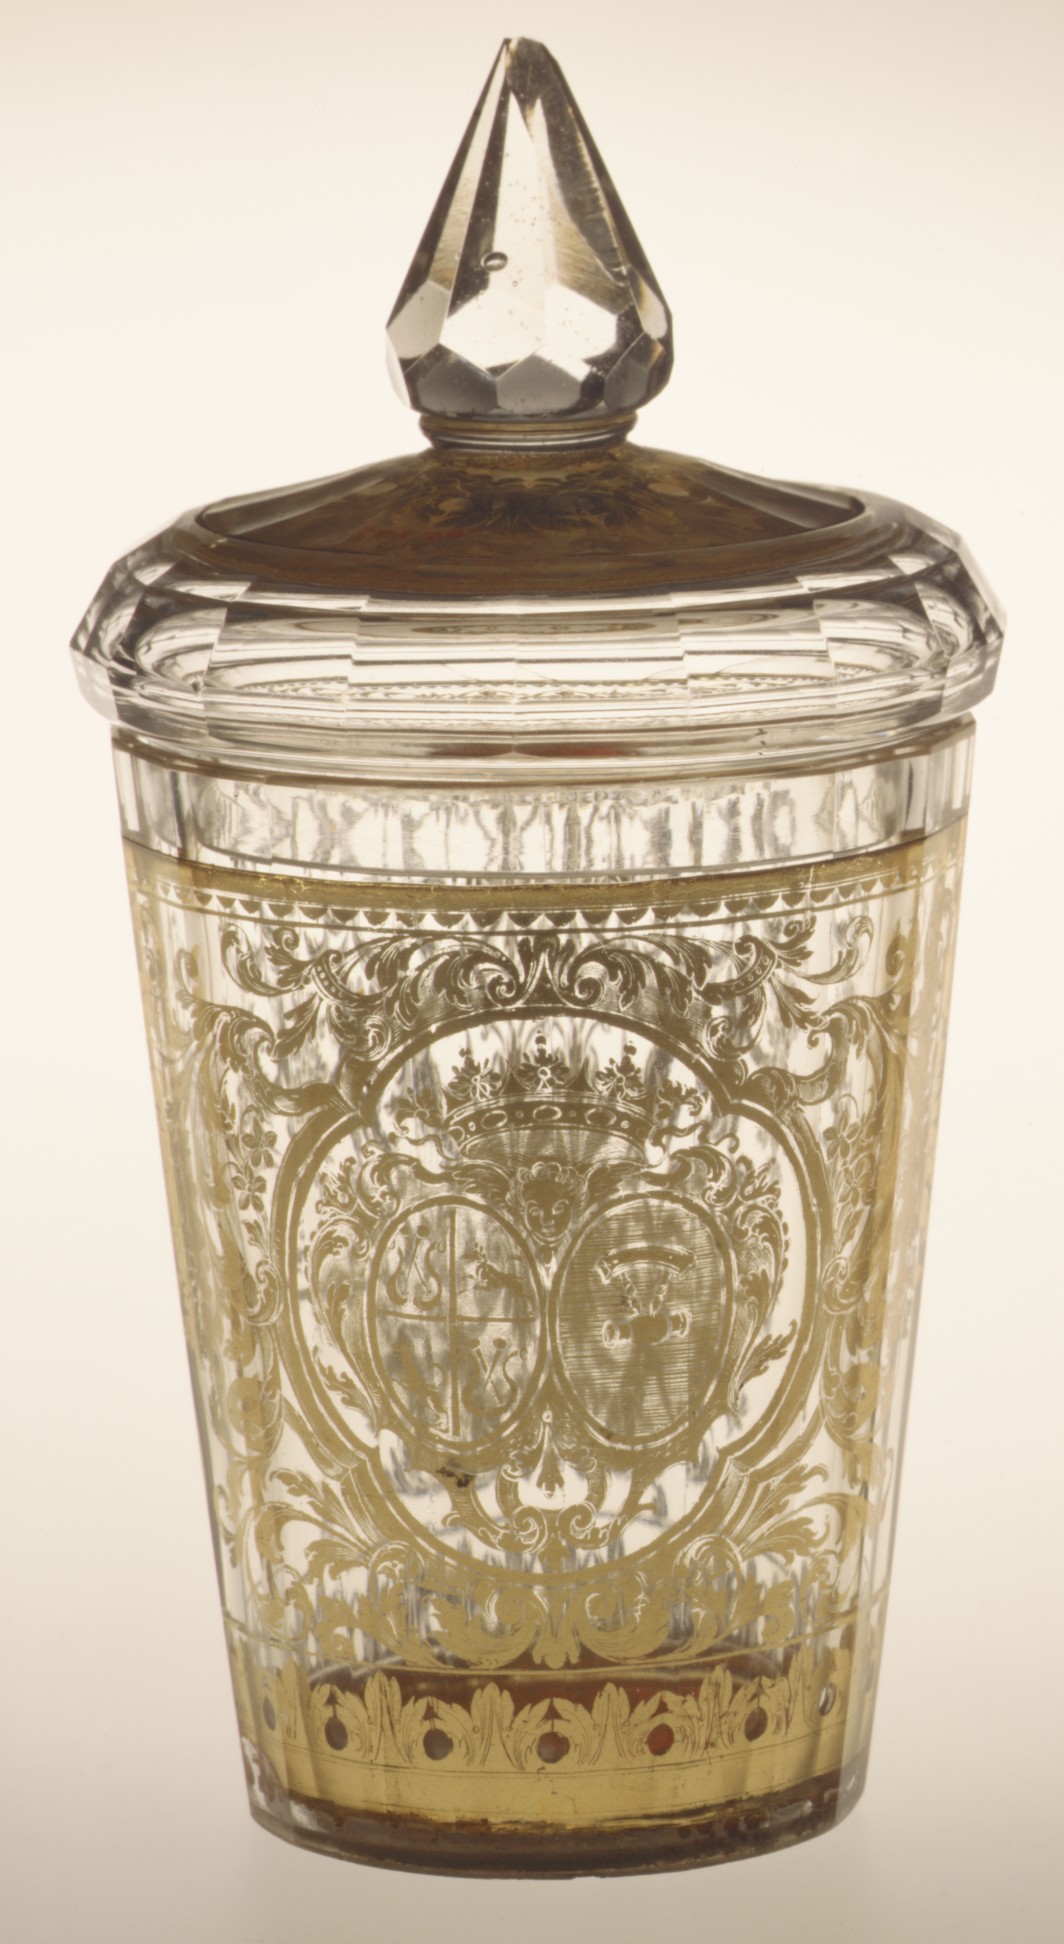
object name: beaker with cover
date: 1730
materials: glass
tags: coat of arms